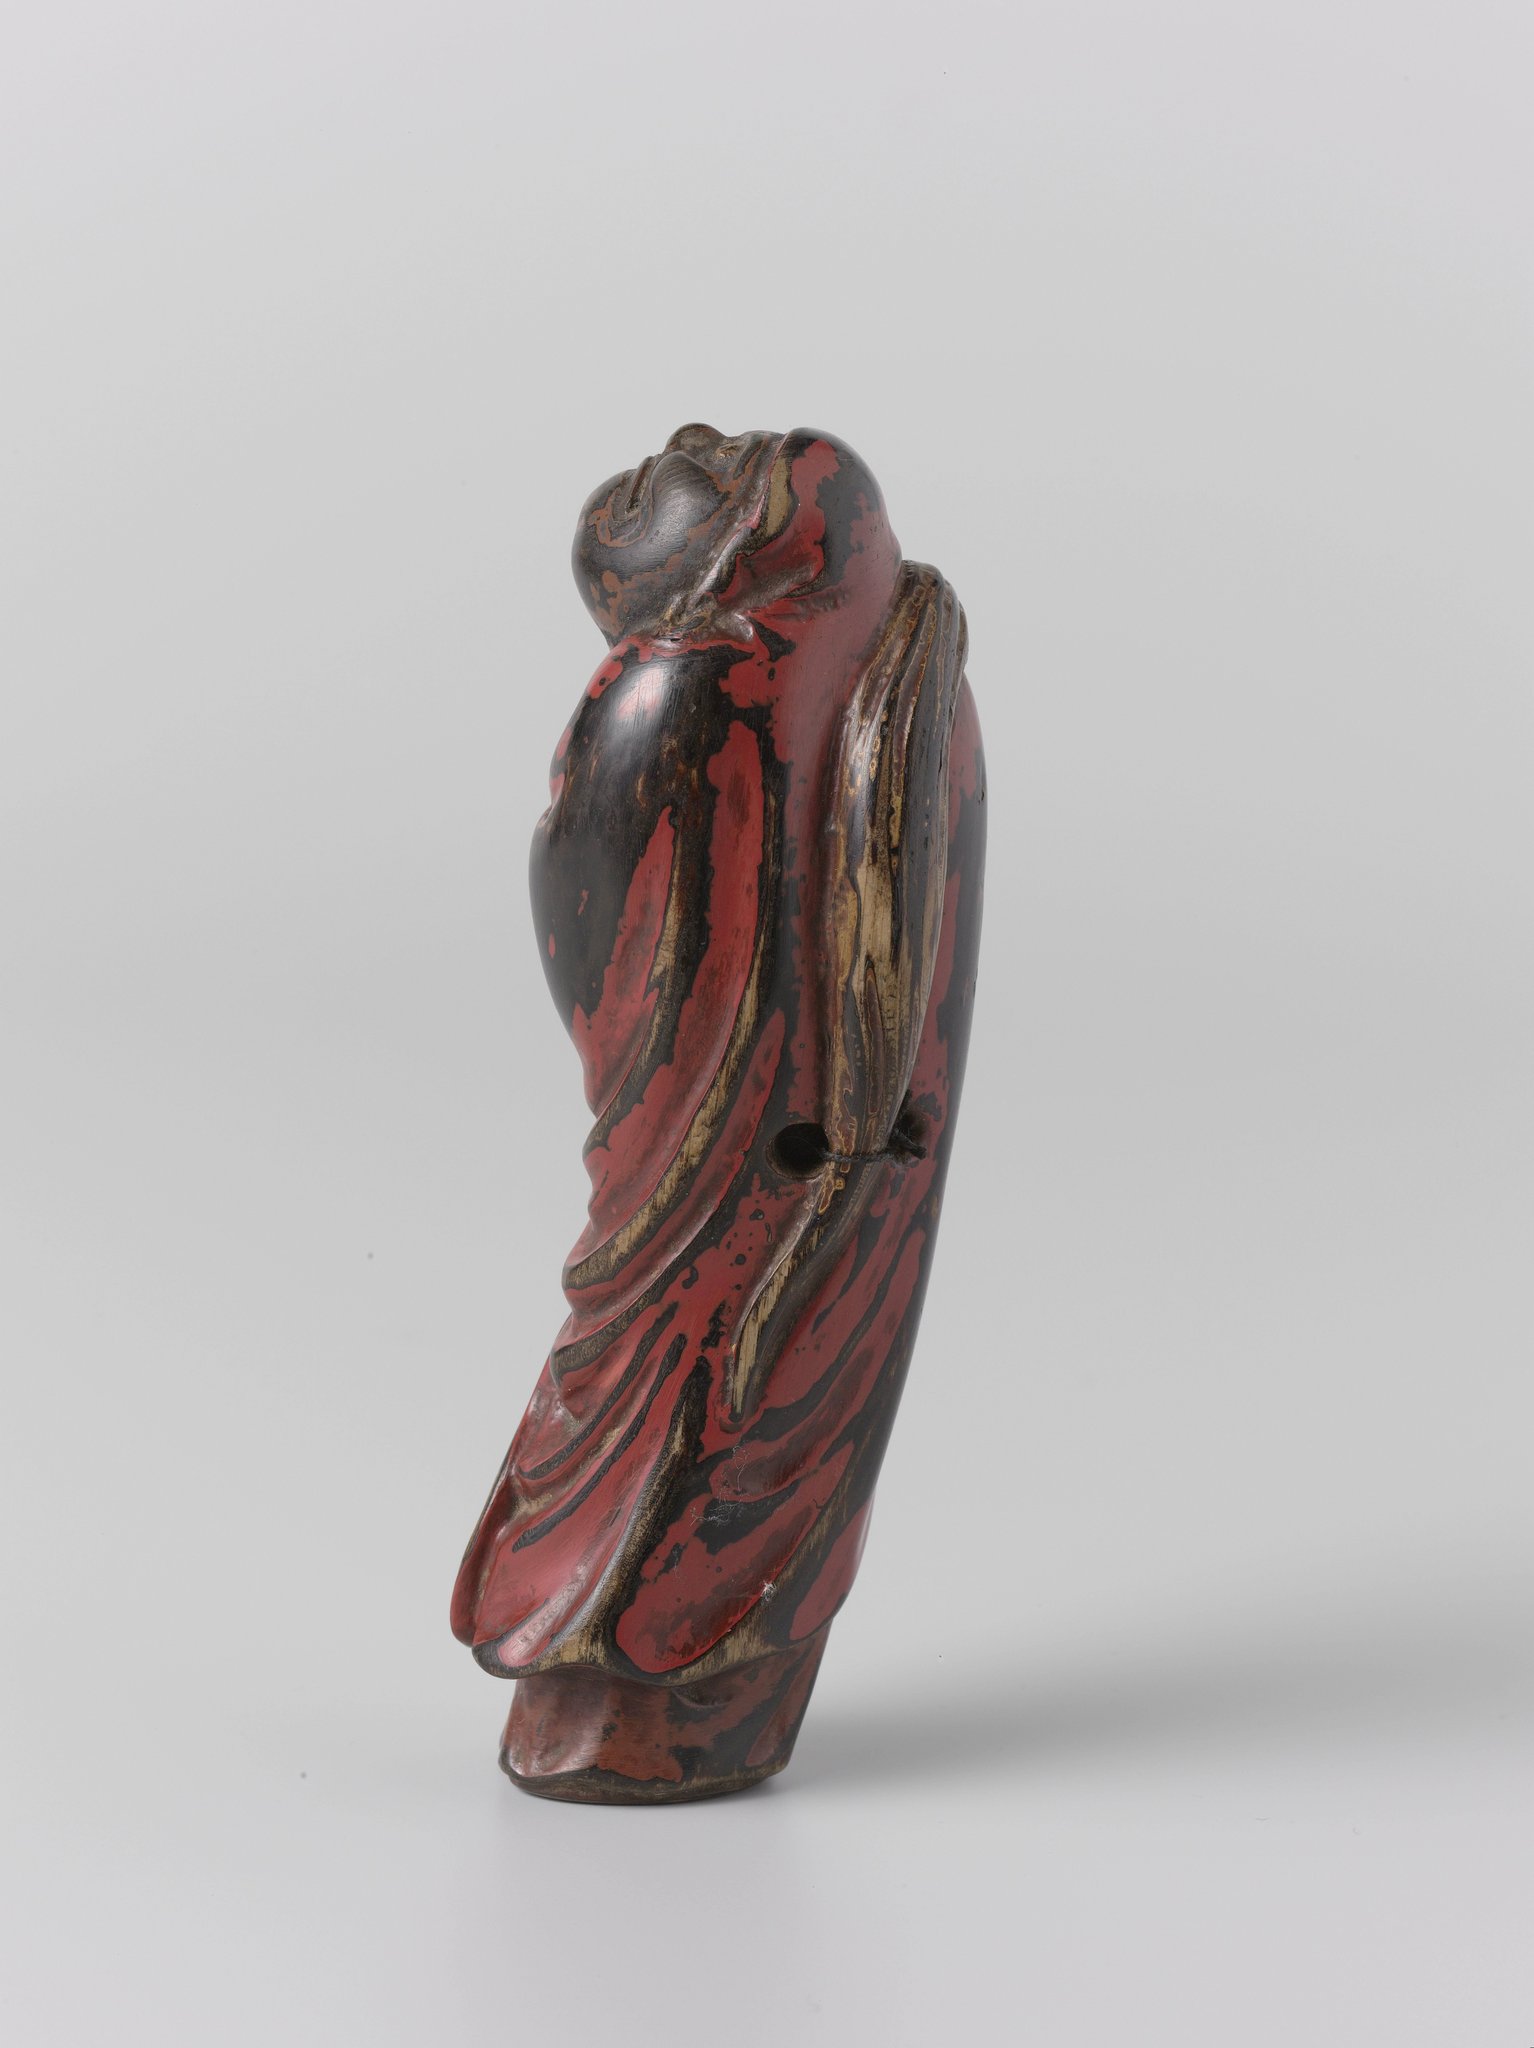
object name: netsuke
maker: Anonymous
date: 1600-1800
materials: red lacquer, wood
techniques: lacquer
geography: japan